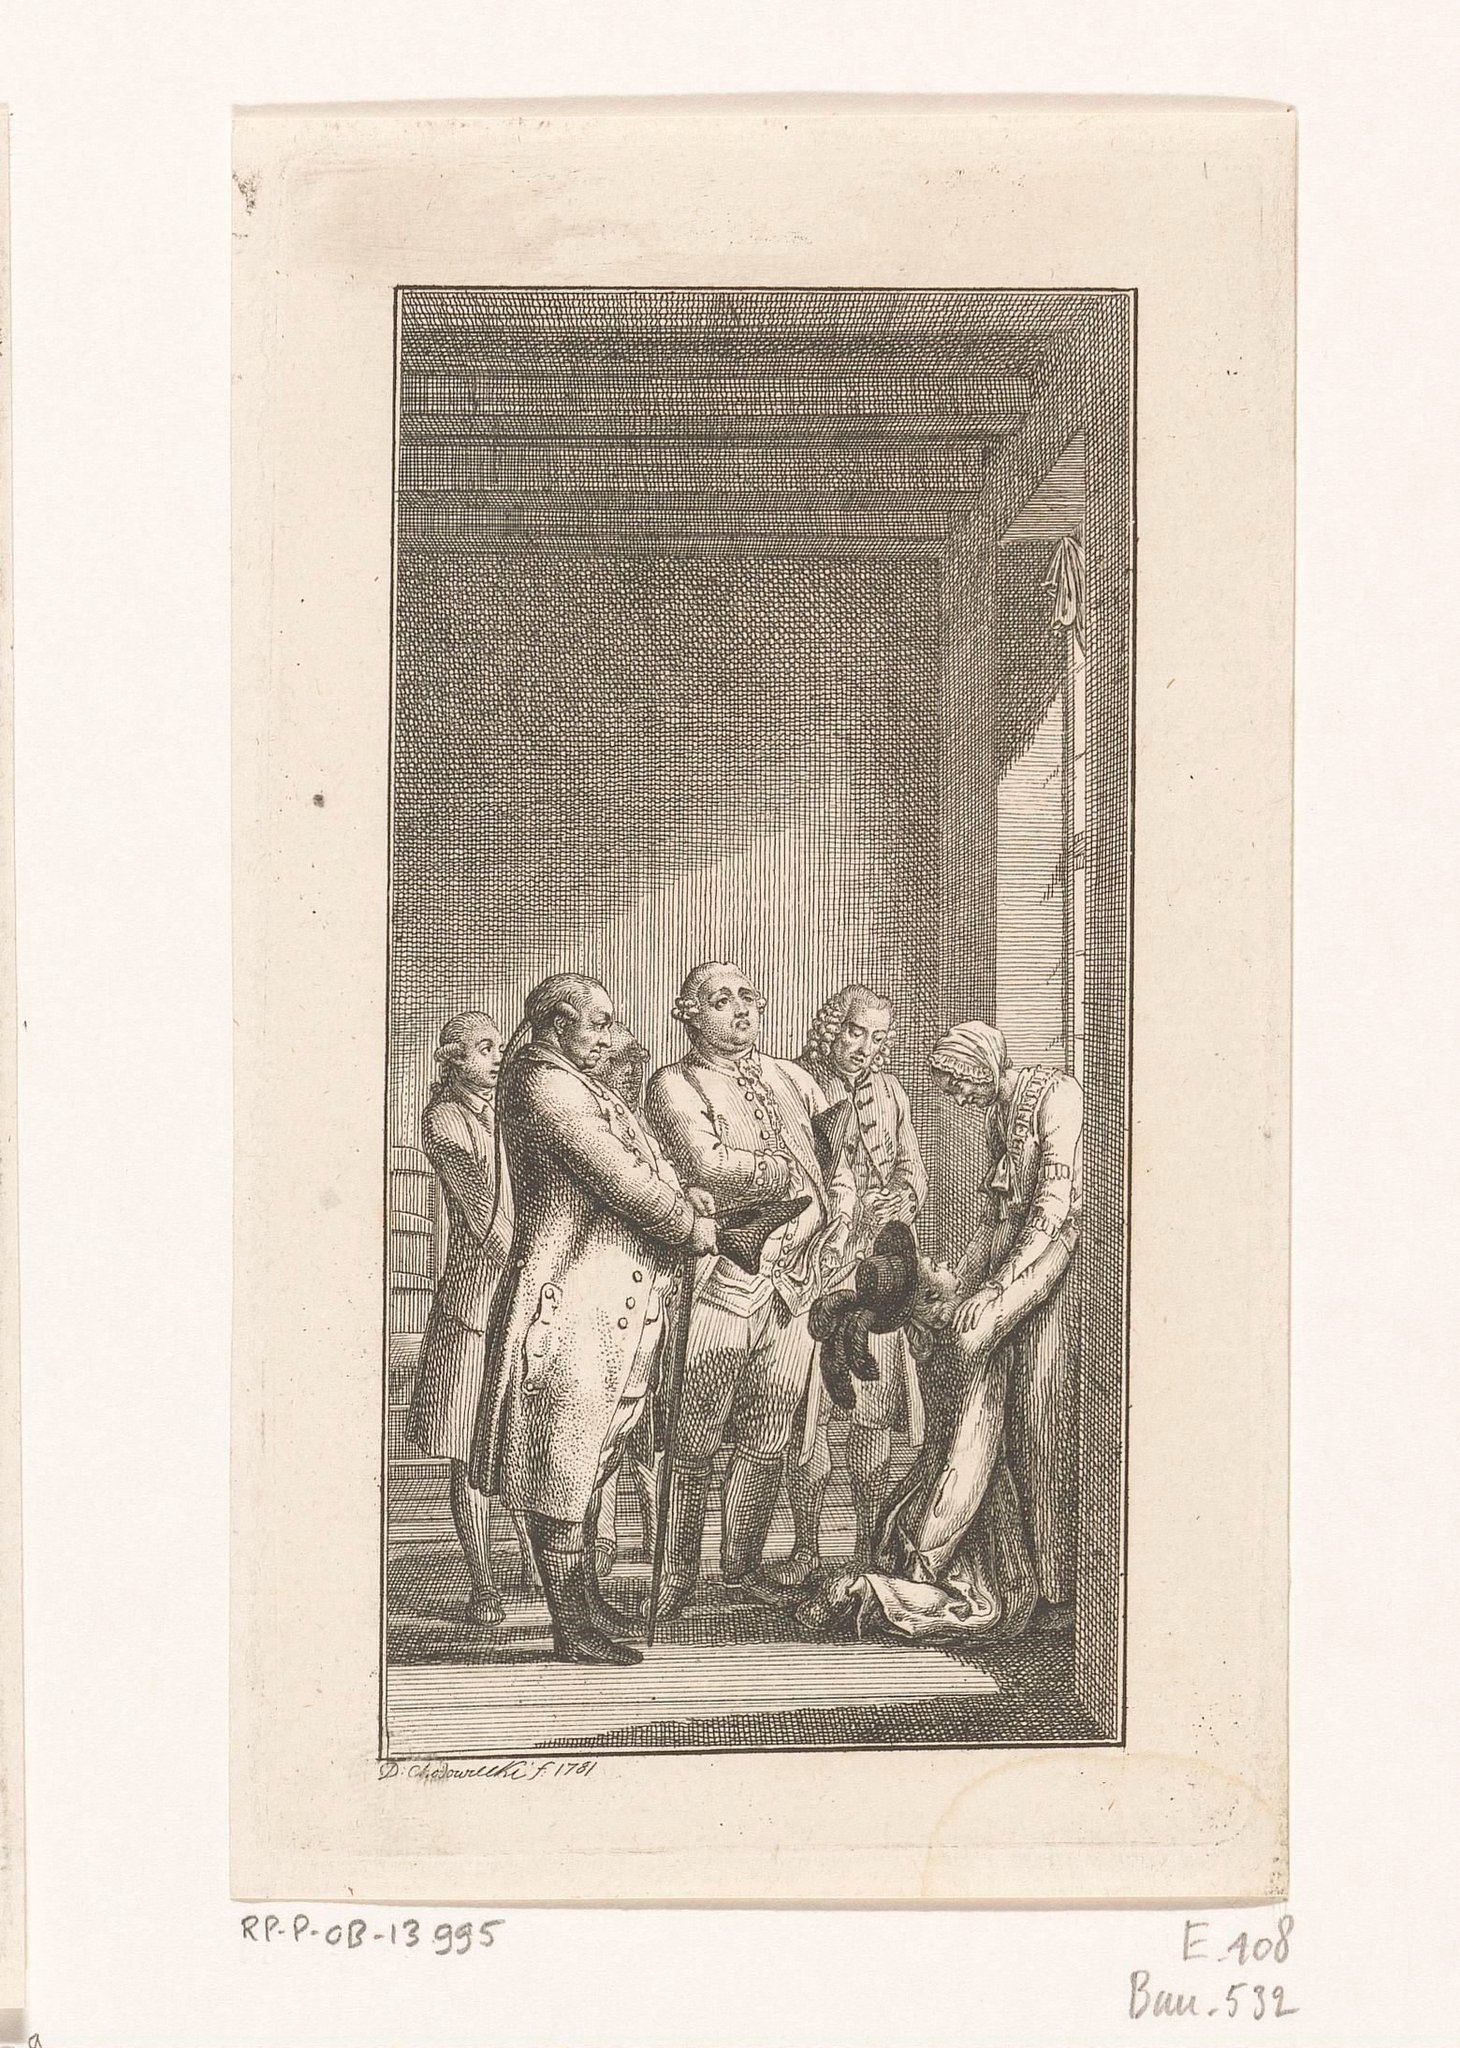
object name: print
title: Gretchen neemt afscheid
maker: daniel nikolaus chodowiecki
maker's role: draughtsman, print maker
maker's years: 1726-1801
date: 1781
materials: paper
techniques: etching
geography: berlin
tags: literature, kneeling figure, kneeling on both knees - aa - female human figure, human figure at (open) window, seen from inside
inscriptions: collector's mark: Lugt 2228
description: Scène afkomstig uit een serie van 24 voorstellingen. Serie ook gebruikt in: Hippel, Theodor Gottlieb von. Lebensläufe nach Aufsteigender Linie nebst Beylagen A, B, C. 3 dln. Berlijn: Christian Friedrich Voß, 1778-1781.